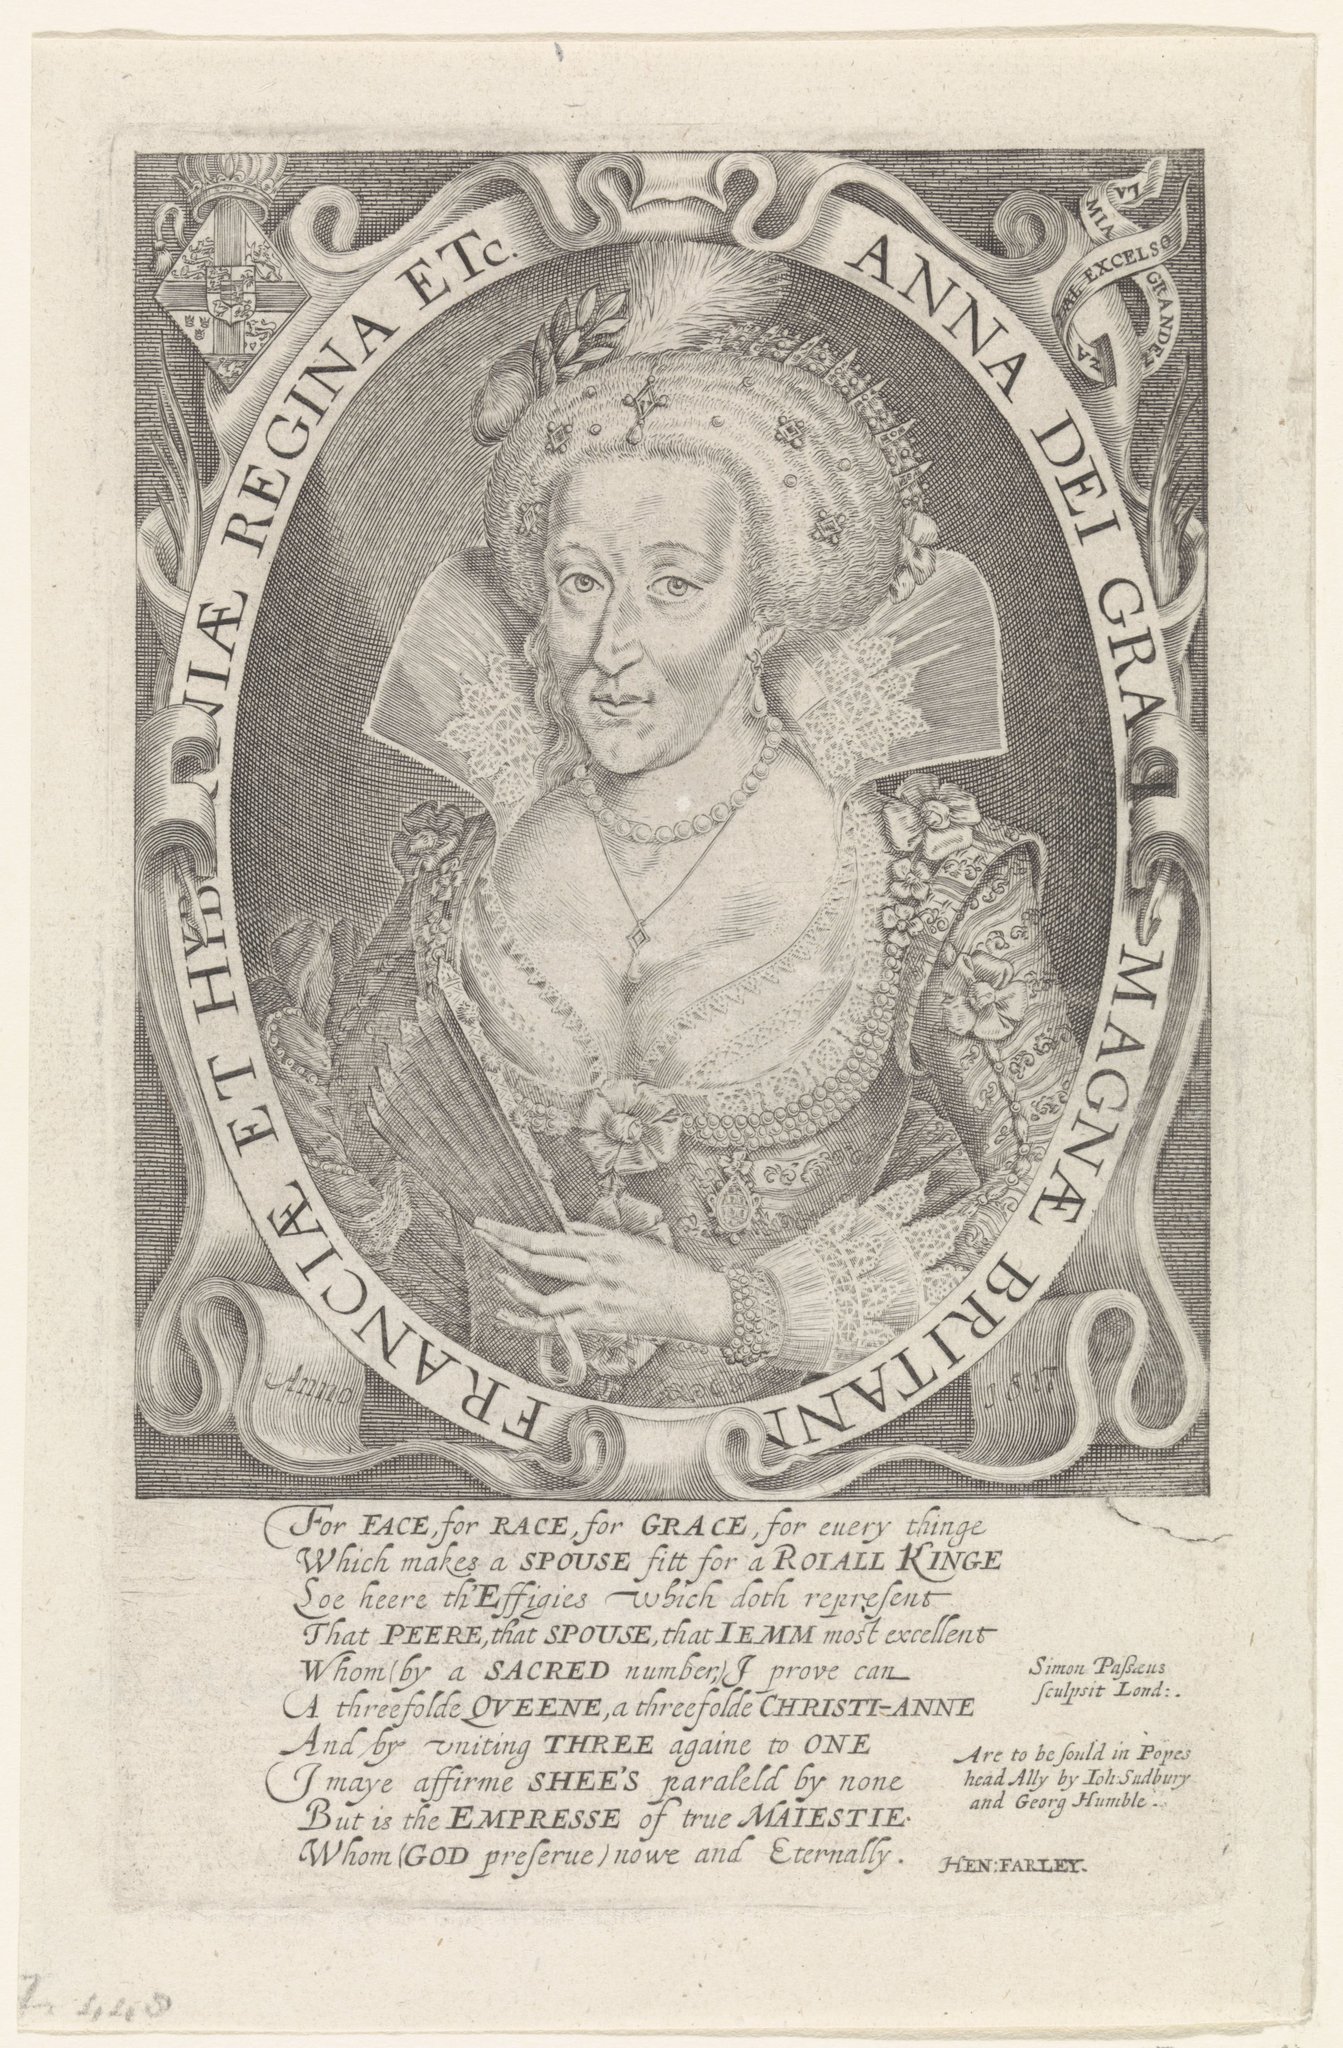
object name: print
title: Busteportret van Anna van Denemarken, koningin van Engeland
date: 1617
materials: paper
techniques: engraving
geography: london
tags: fan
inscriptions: collector's mark: Lugt 2228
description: Busteportret van Anna van Denemarken, gemalin van koning Jacobus I van Engeland. In haar linkerhand houdt ze een waaier. Linksboven het gecombineerde wapenschild van Engeland en Denemarken. In het randschrift van de omlijsting de naam en functie van de geportretteerde in het Latijn. In de marge een tienregelig lofdicht in het Engels.